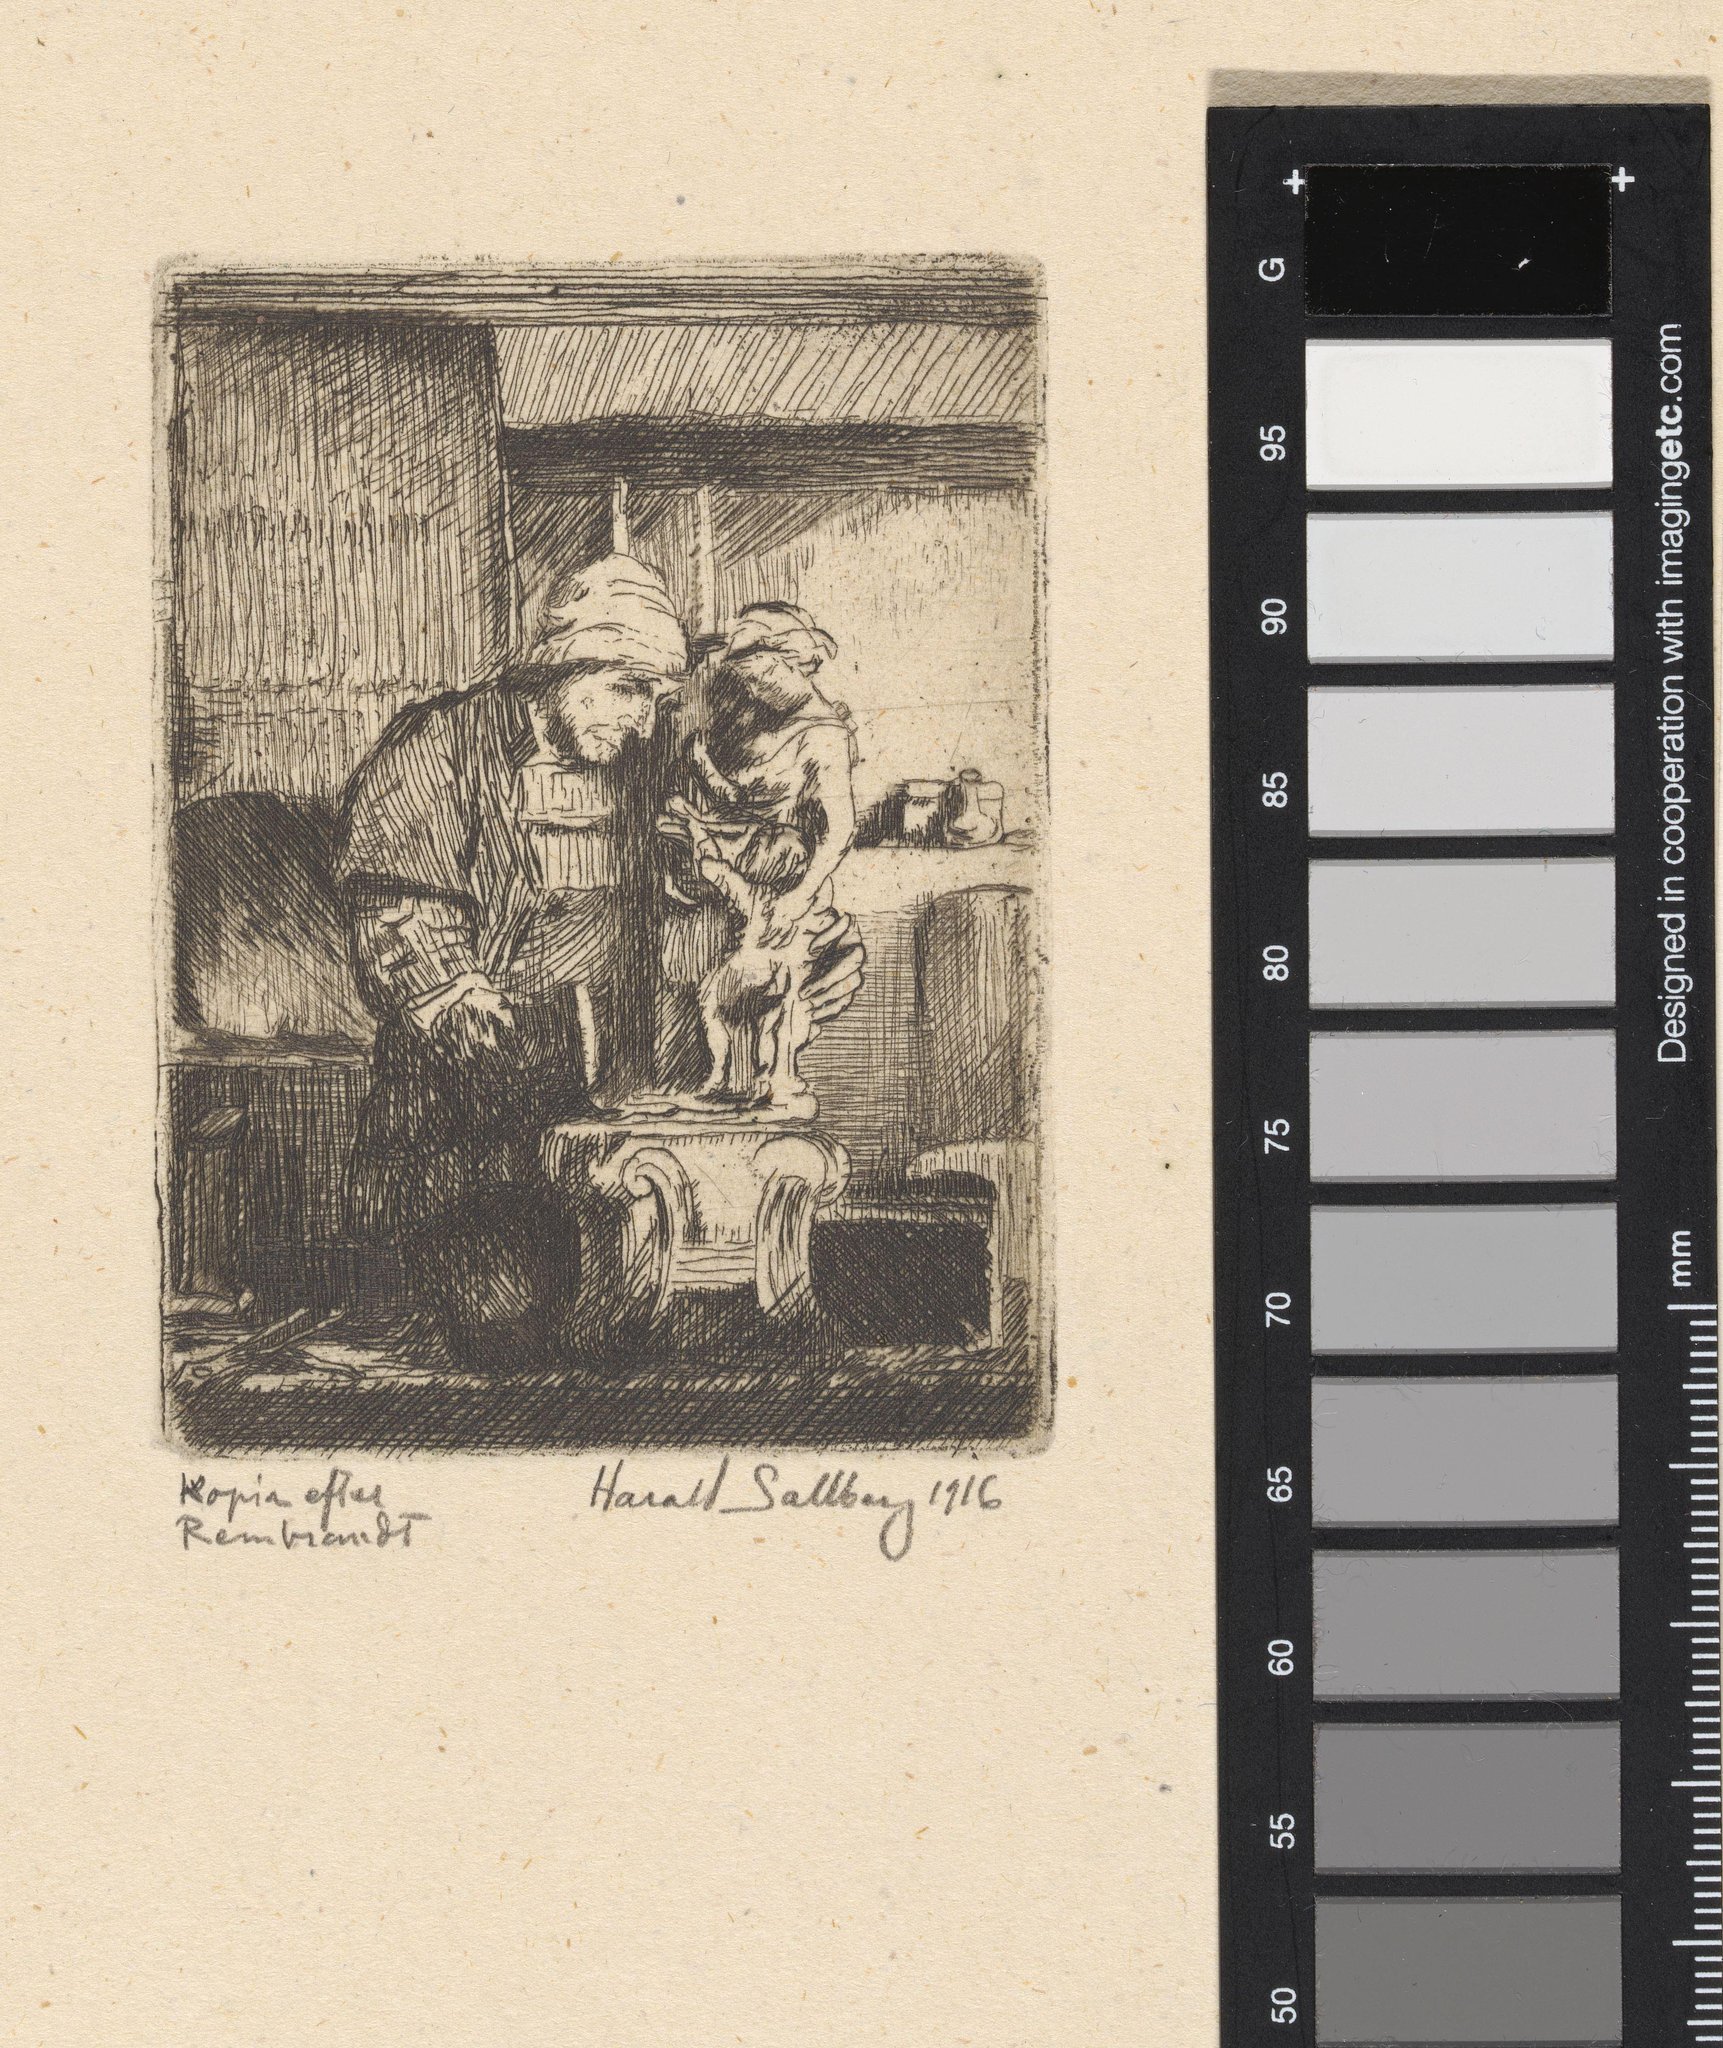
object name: print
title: The goldsmith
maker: harald arthur sallberg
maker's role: print maker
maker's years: 1895-1963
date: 1916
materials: paper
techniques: etching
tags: jeweller, goldsmith, silversmith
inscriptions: collector's mark: Lugt 2228, signature: ‘Kopïa after Rembrandt Harald Sallberg 1916’, collector's mark: Lugt 2760